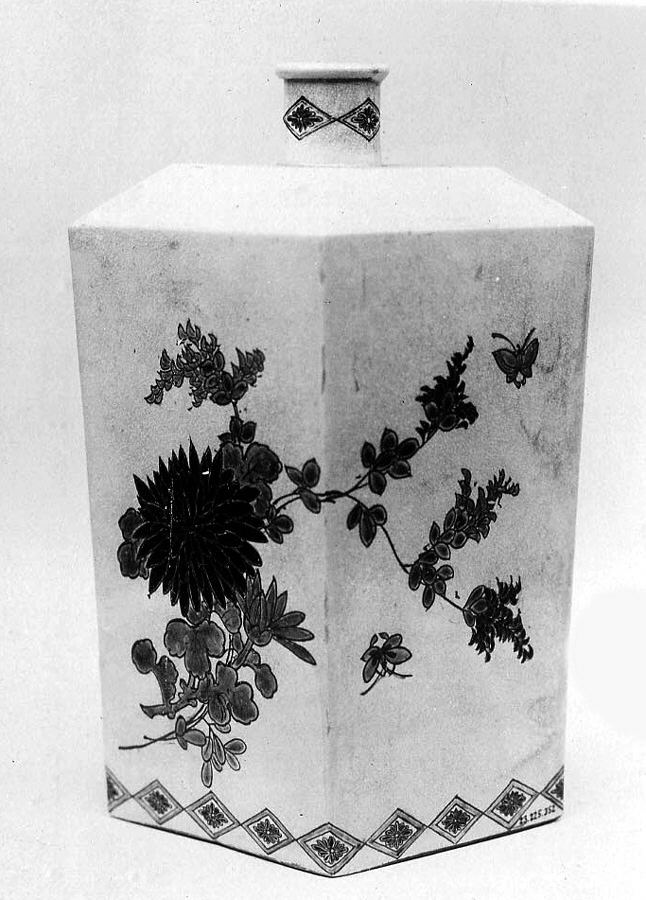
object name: wine bottle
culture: japanese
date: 1850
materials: enamel, faience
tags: butterflies,flowers